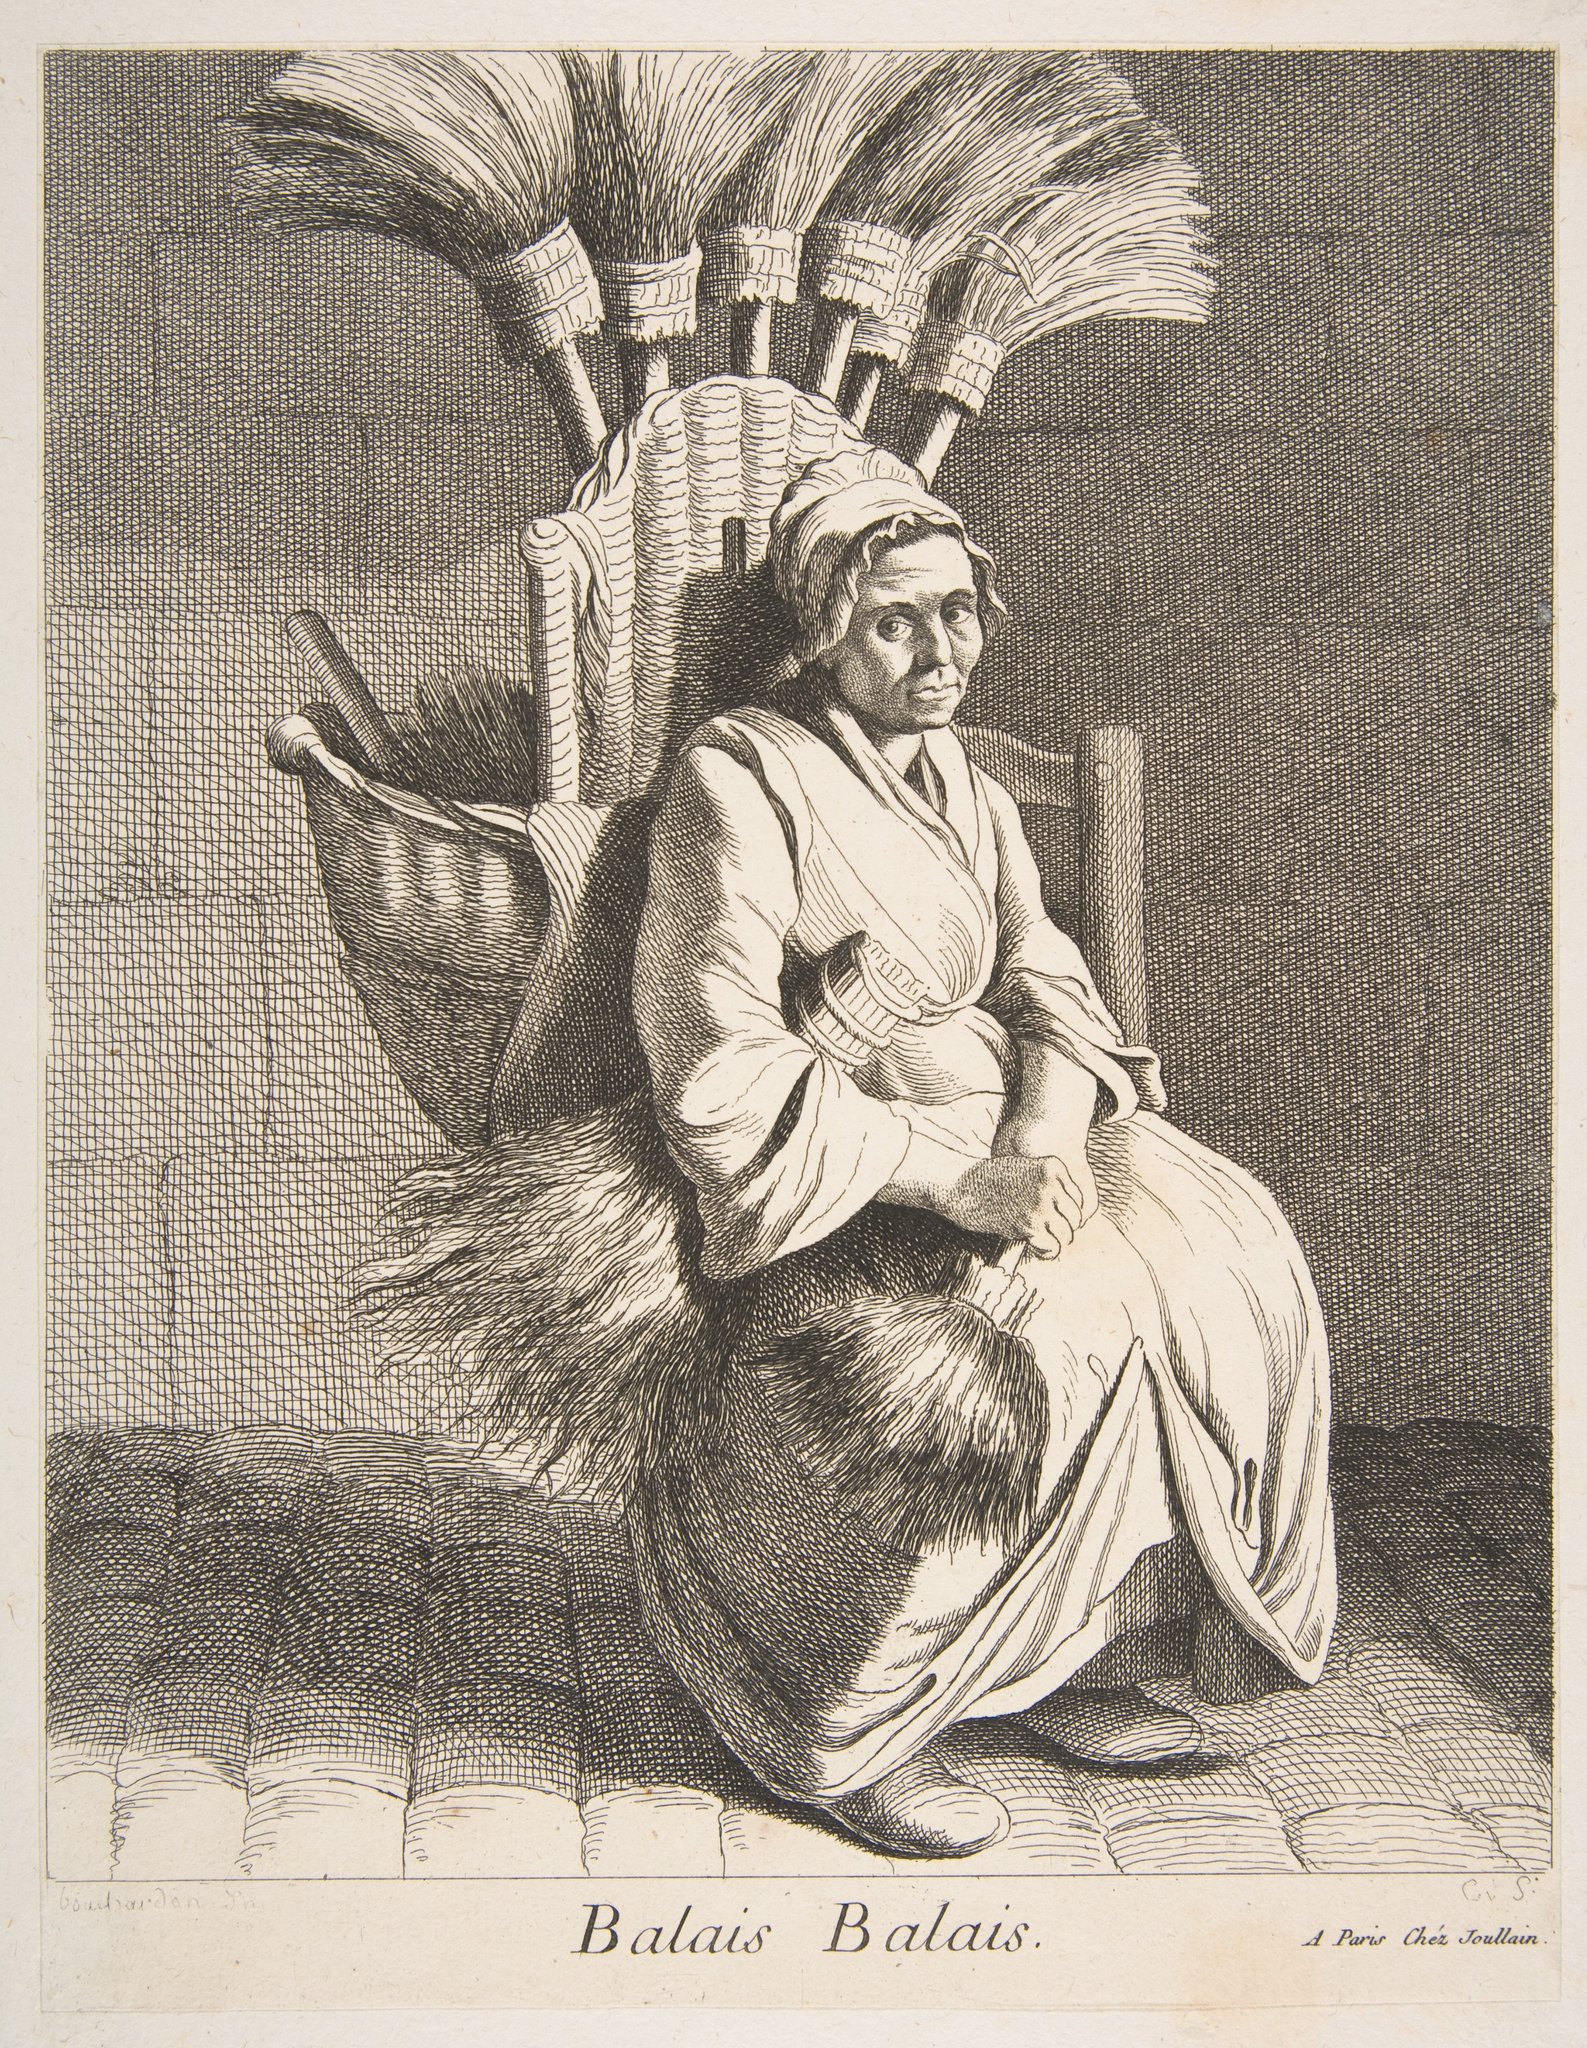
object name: print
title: Broom Peddler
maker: anne claude philippe de tubières, comte de caylus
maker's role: artist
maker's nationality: french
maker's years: 1692-1765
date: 1737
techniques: engraving, etching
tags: women,brooms